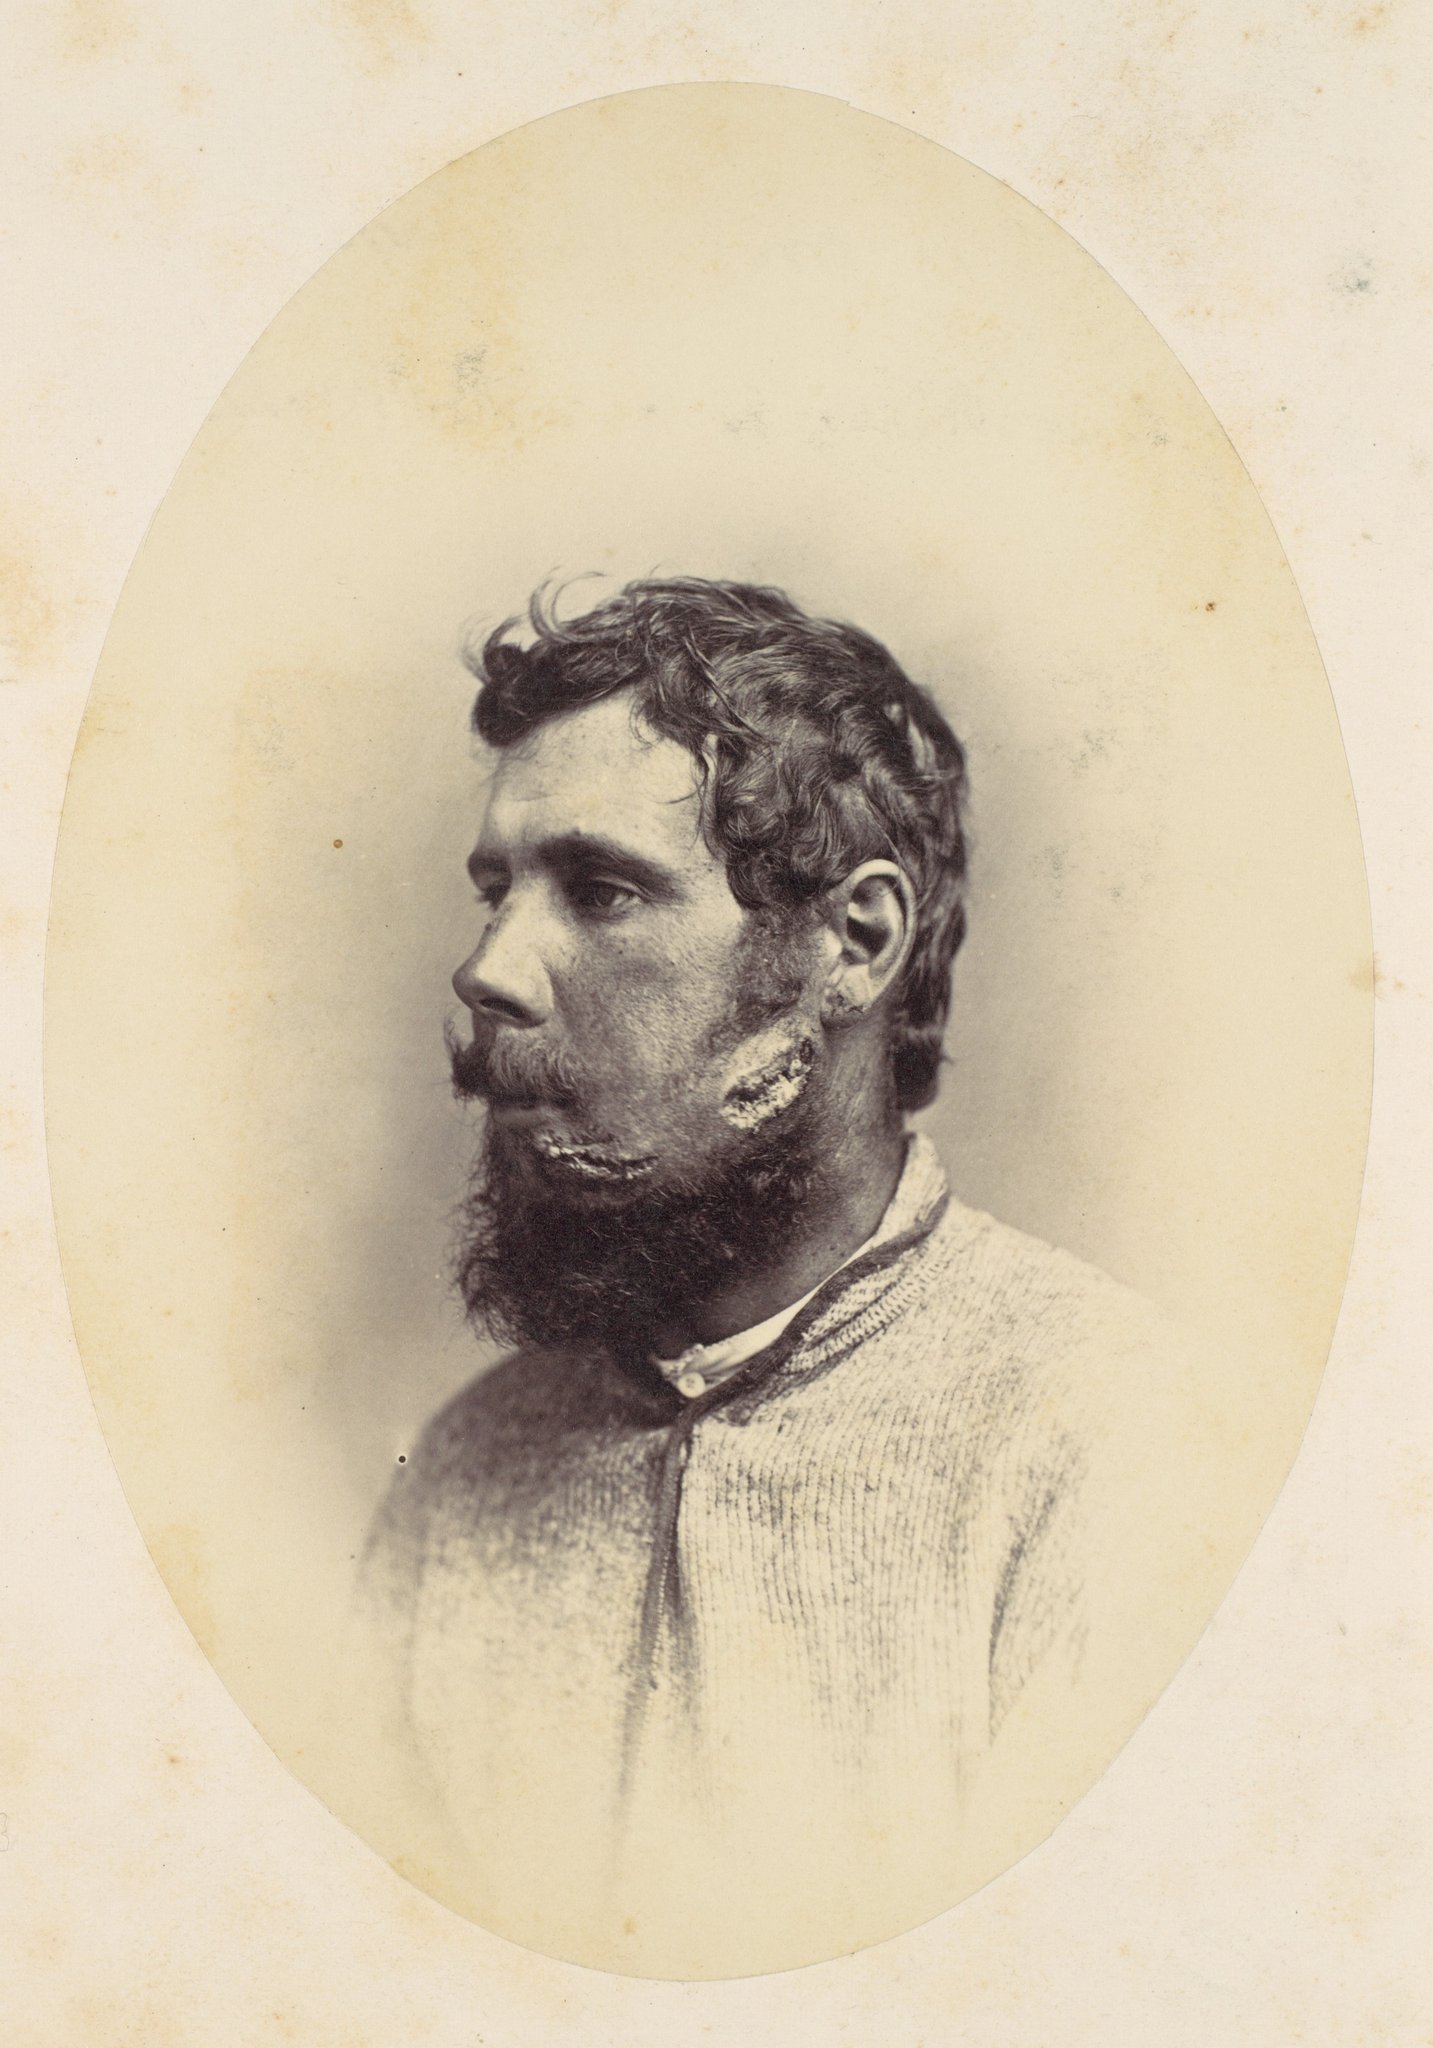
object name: photograph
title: Andrew Wagoner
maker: reed brockway bontecou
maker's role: artist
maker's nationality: american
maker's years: 1824-1907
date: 1865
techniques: albumen silver print, glass negative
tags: soldiers,american civil war,men,portraits